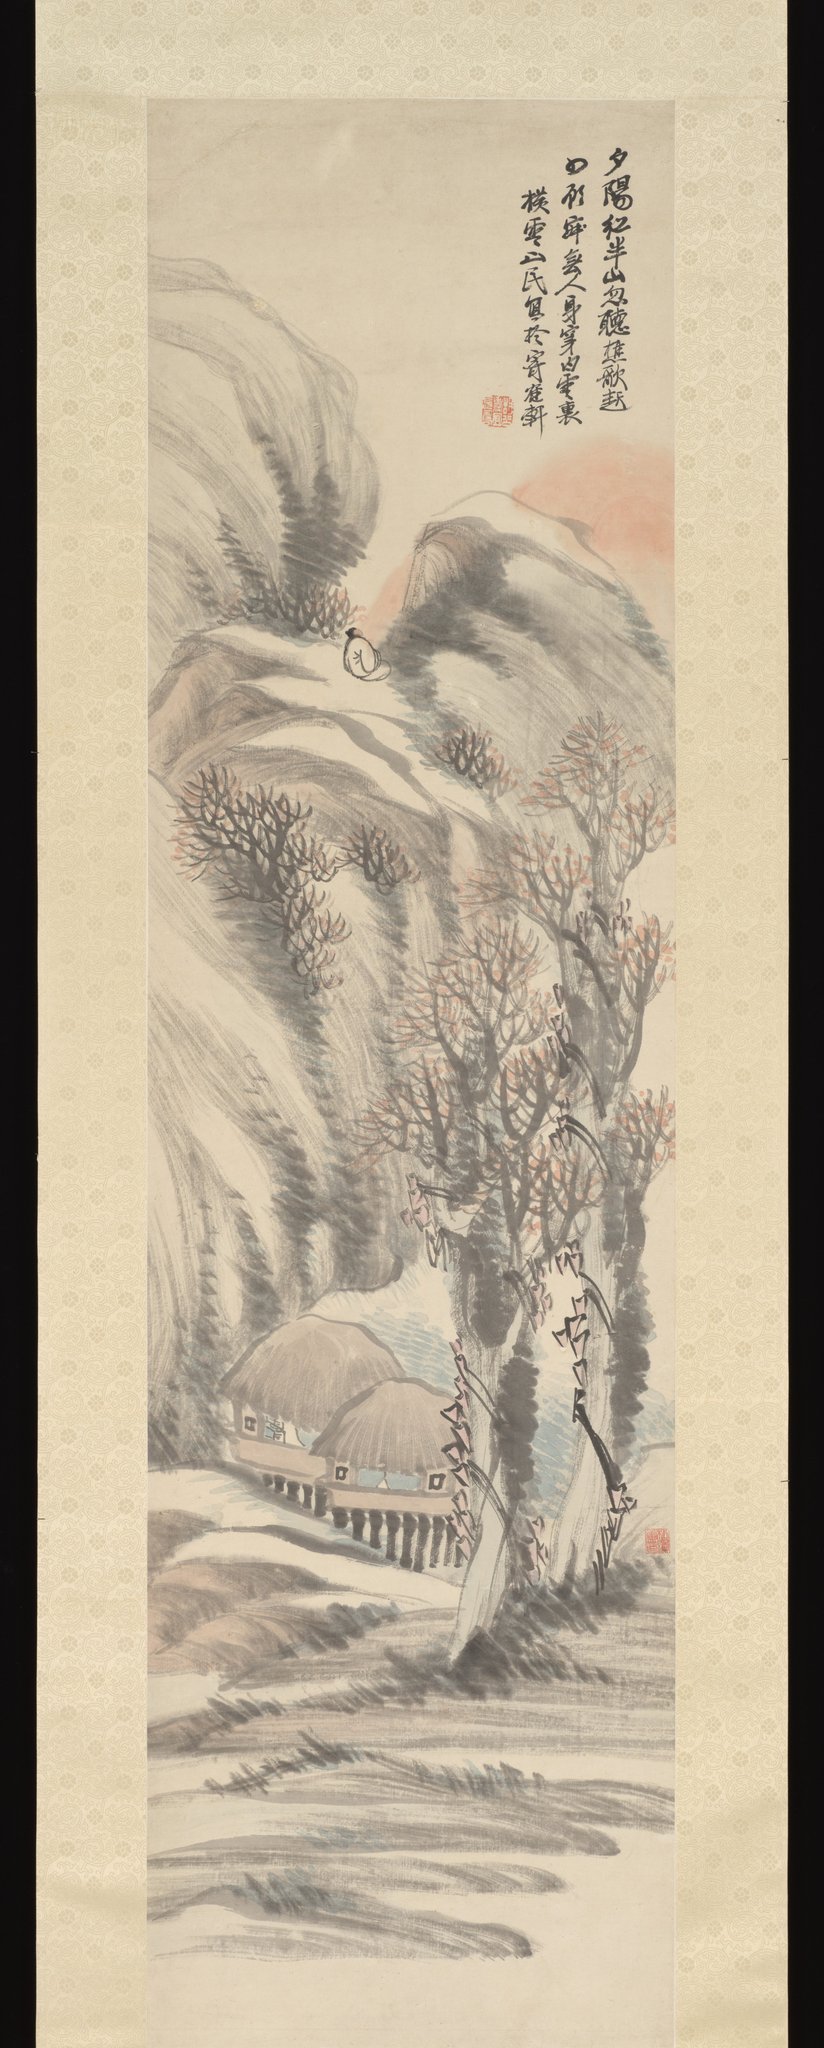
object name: hanging scroll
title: Landscape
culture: chinese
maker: hu yuan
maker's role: artist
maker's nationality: chinese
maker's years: 1823-1886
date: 1823-1886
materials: ink, paper